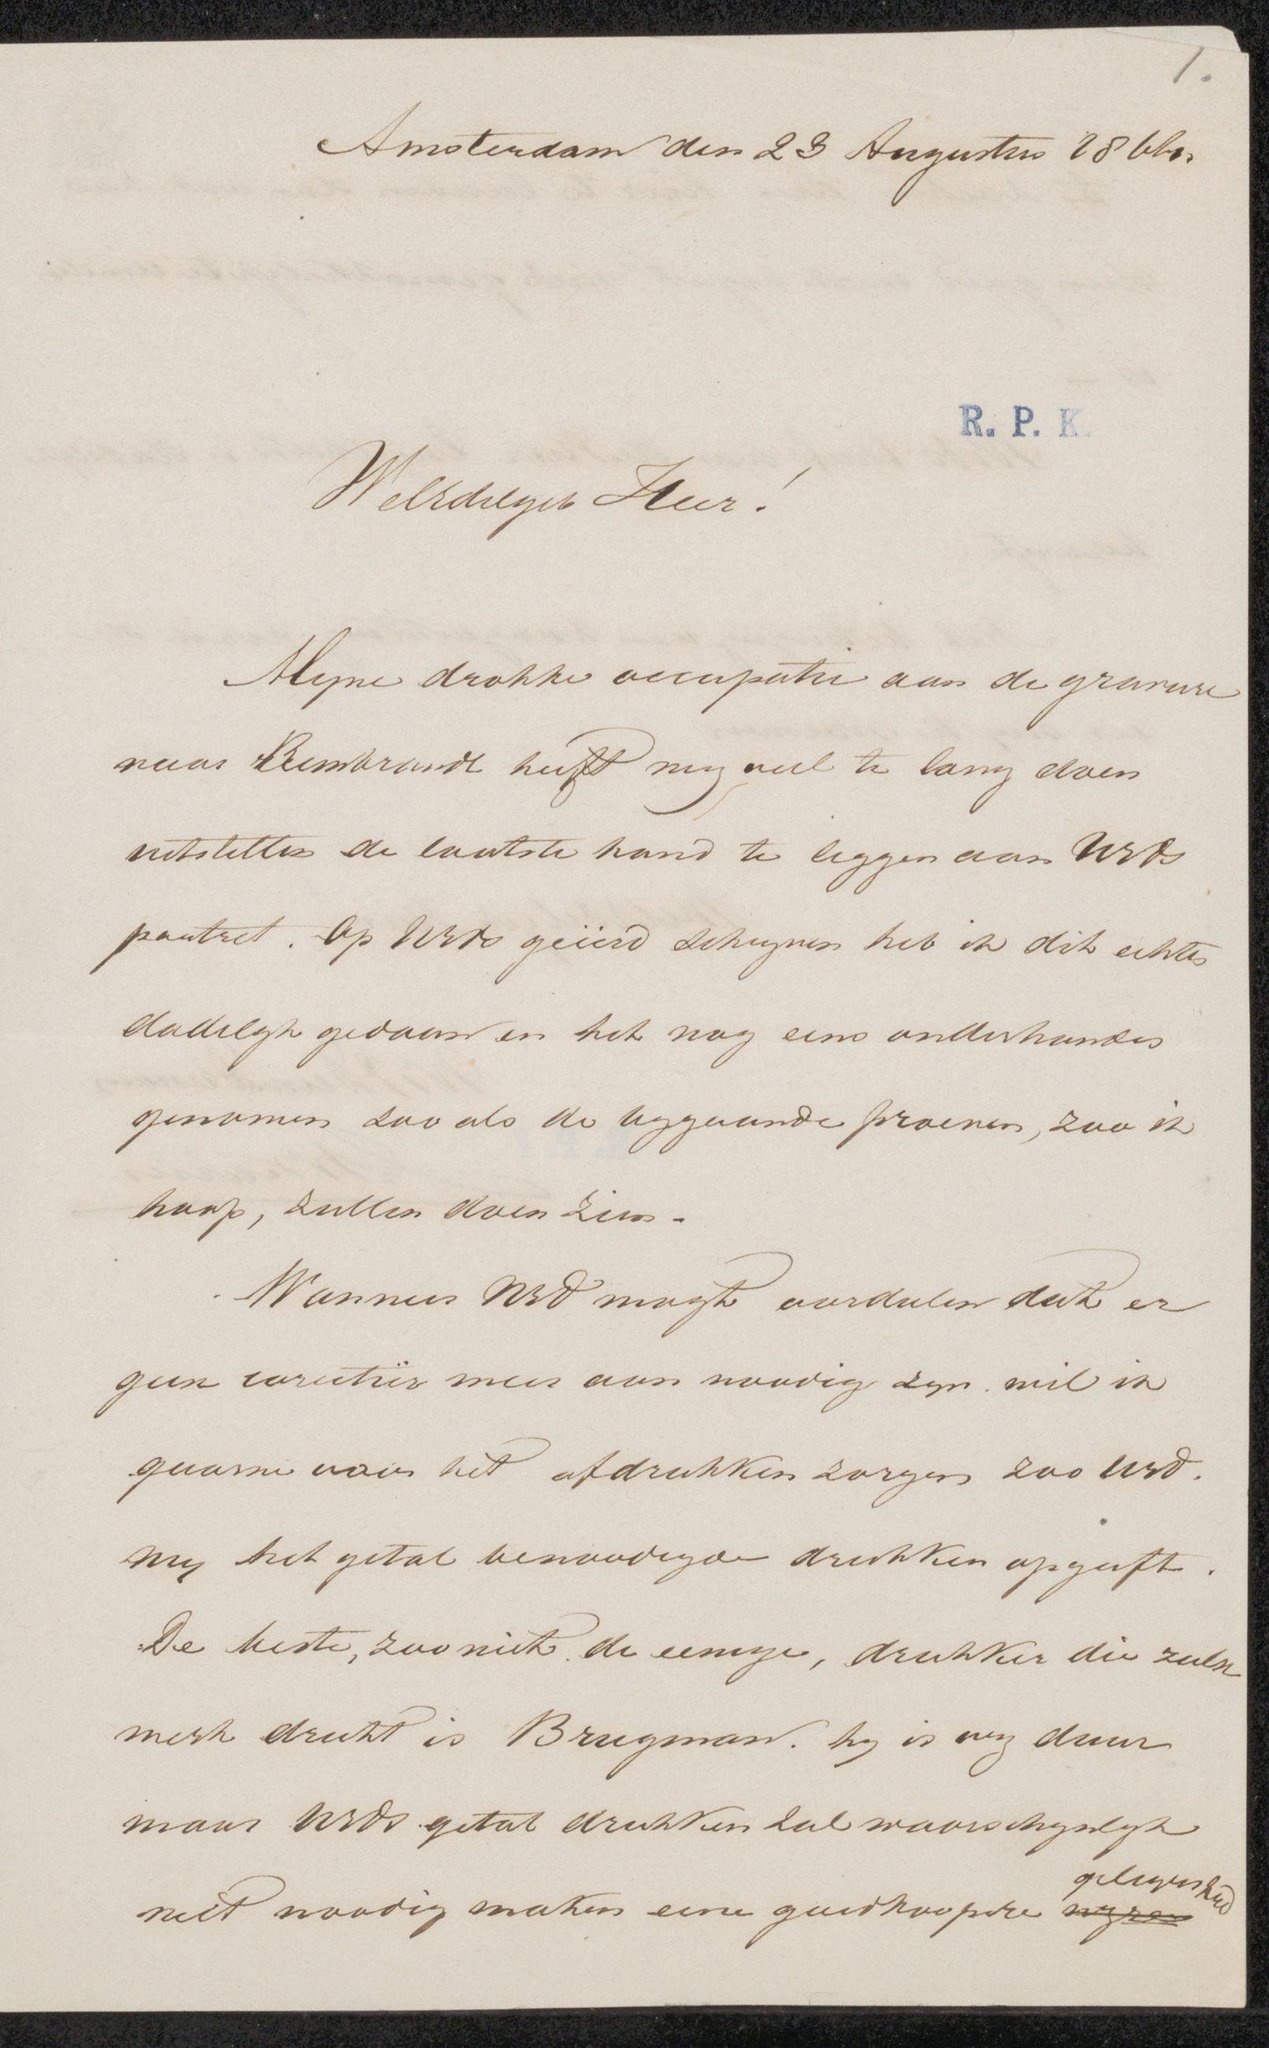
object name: letter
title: Brief aan anoniem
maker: johann wilhelm kaiser (i)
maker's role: draughtsman, print maker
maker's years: 1813-1900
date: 1864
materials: ink, paper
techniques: pen, writing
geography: amsterdam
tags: leiden, amsterdam, painter, print maker, draughtsman, rembrandt van rijn, jacobus franciscus brugman, the graphic arts, anonymous historical person portrayed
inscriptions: collector's mark: Lugt 2233